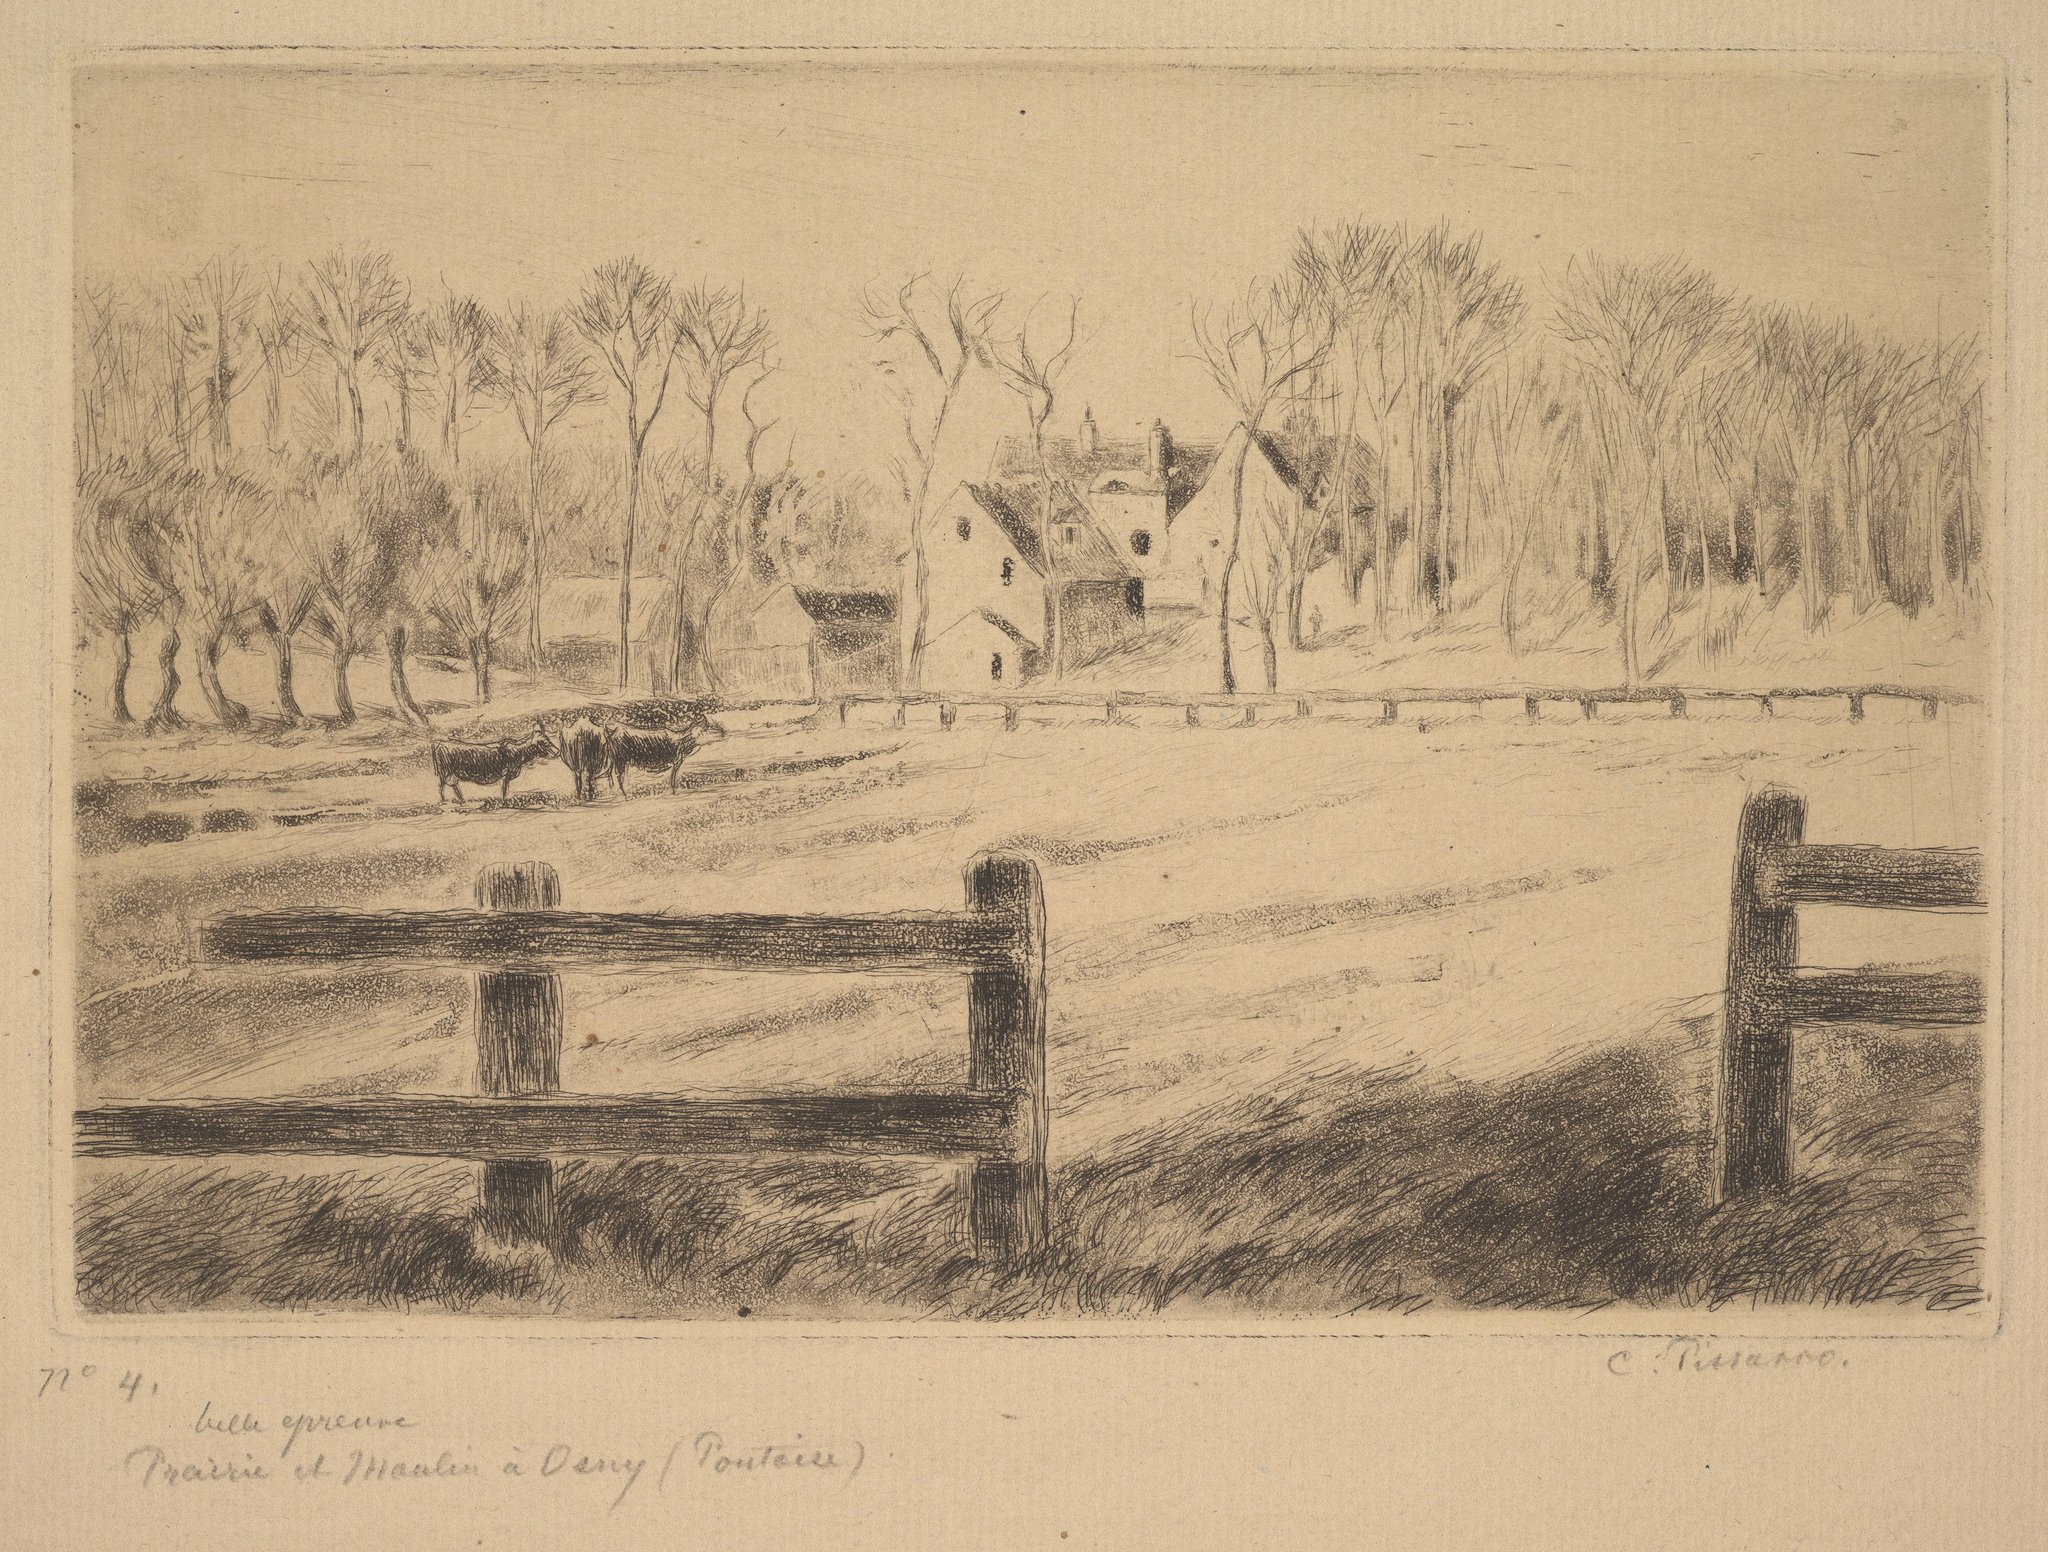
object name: print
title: Field and Mill at Osny (Pontoise), 1885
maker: camille pissarro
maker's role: artist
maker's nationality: french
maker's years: 1830-1903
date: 1885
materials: paper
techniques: aquatint, drypoint, etching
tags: fences,houses,cows